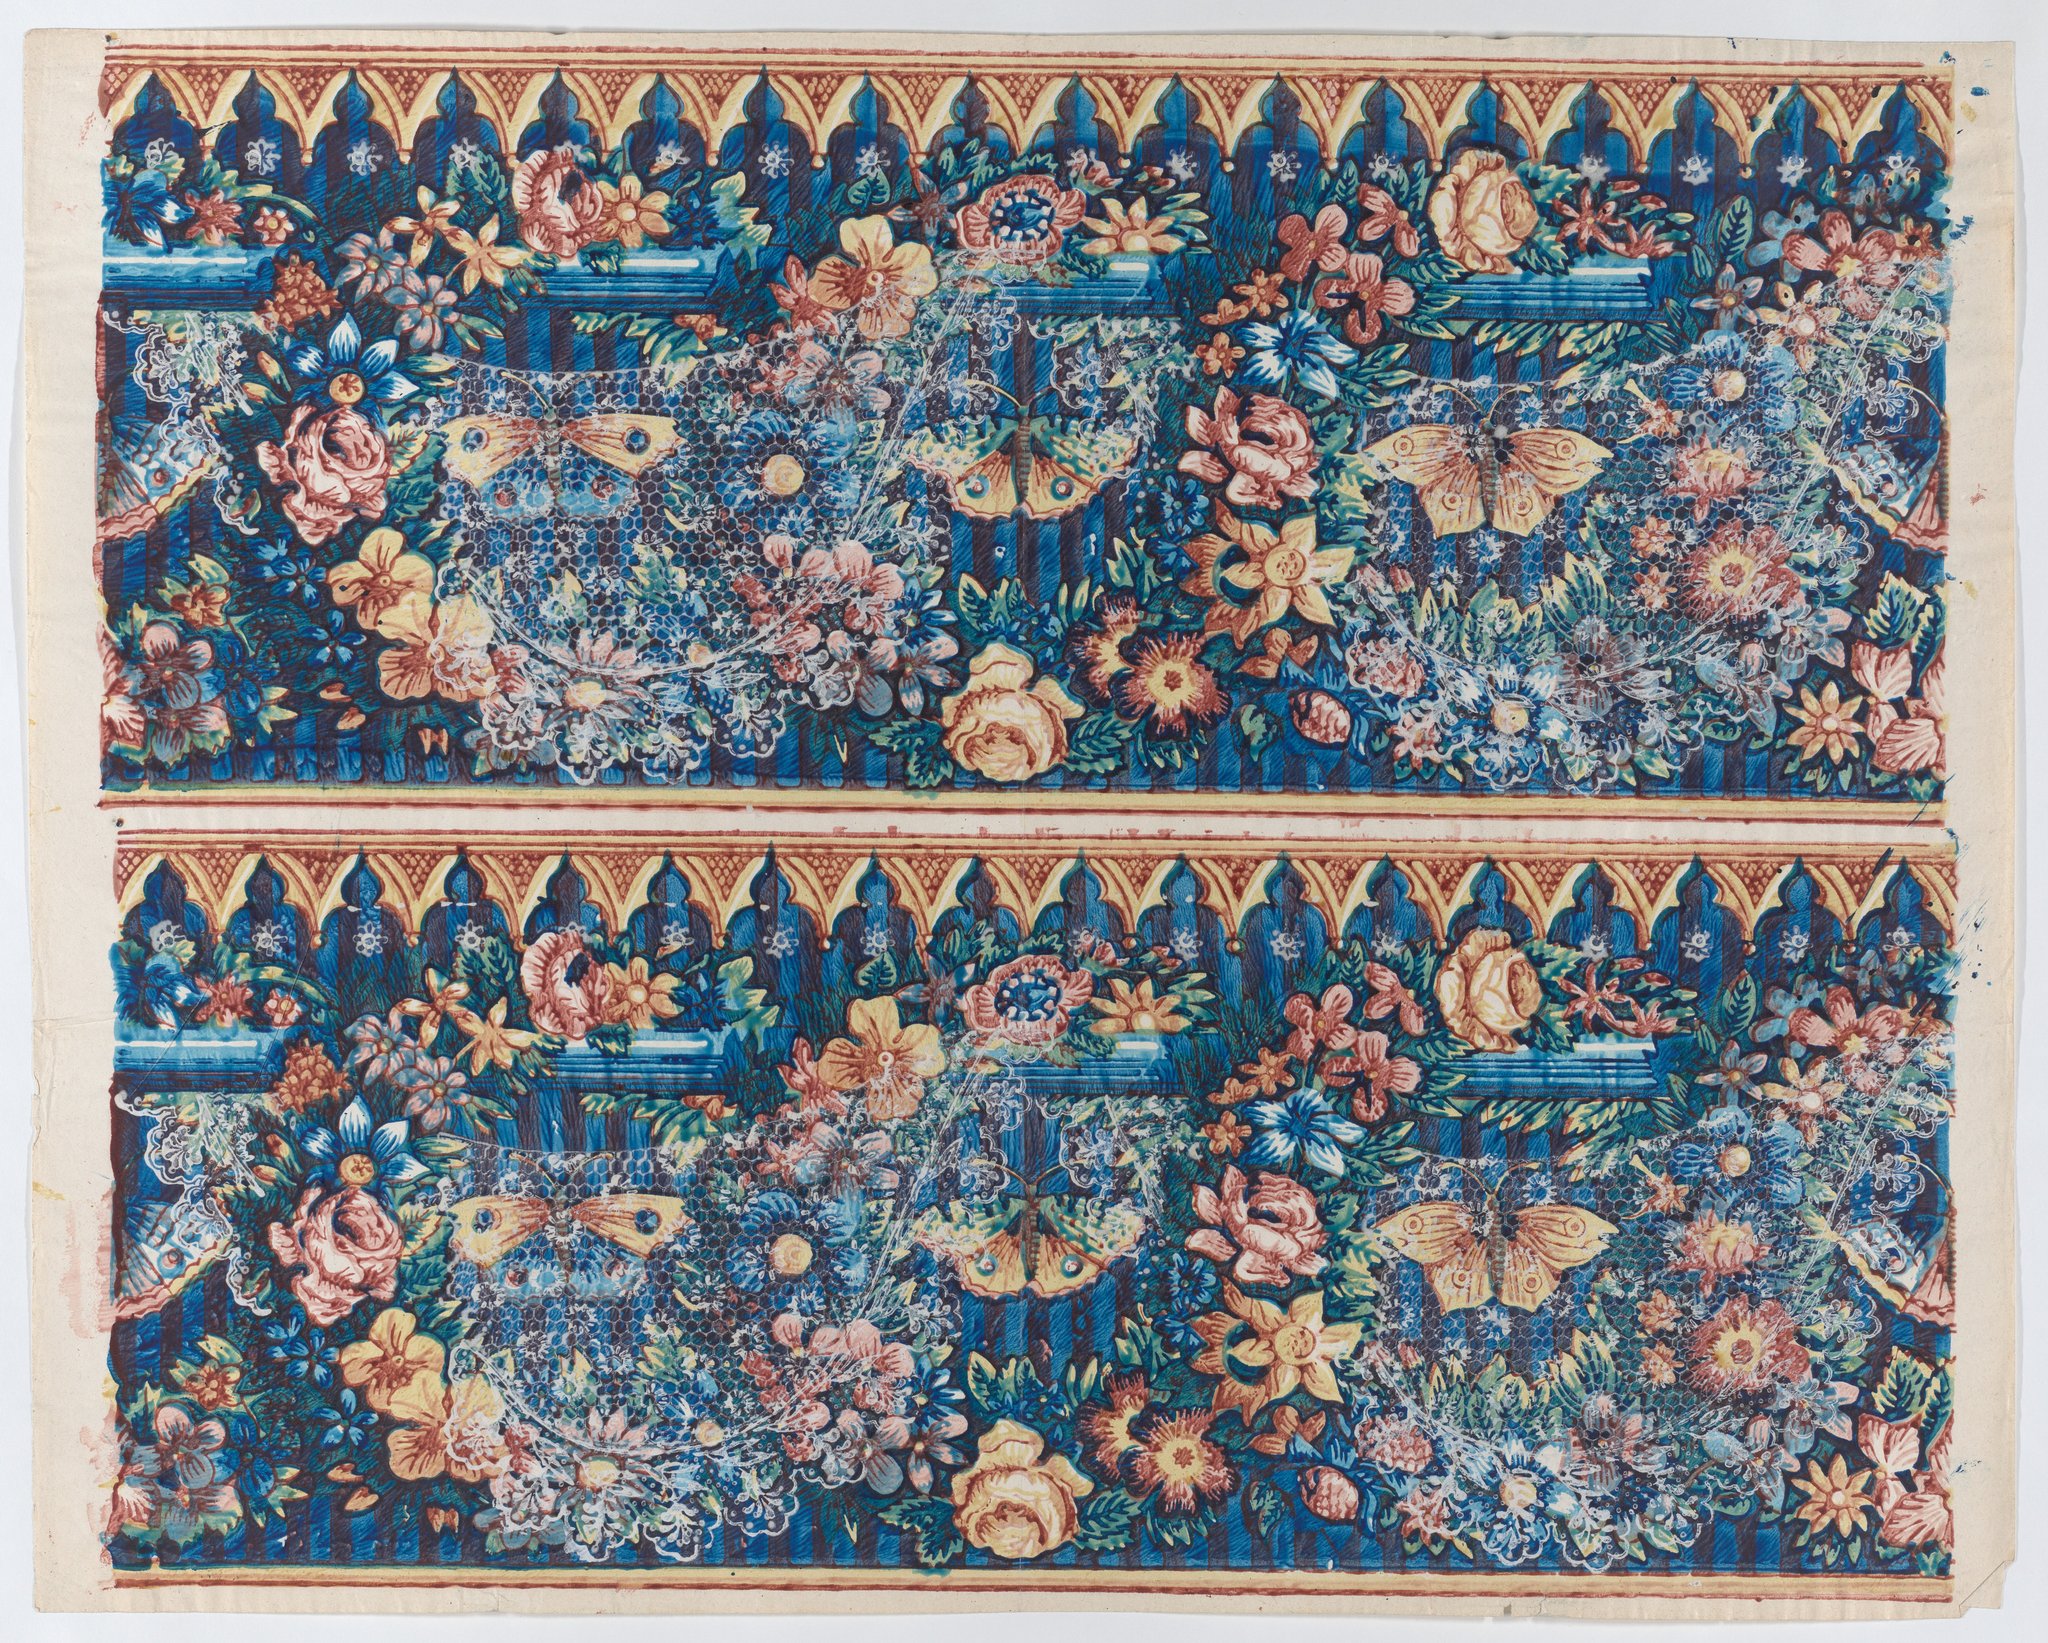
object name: print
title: Sheet with two borders with lace atop floral wreaths and butterflies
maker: Anonymous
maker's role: artist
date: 1767-1866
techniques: relief print